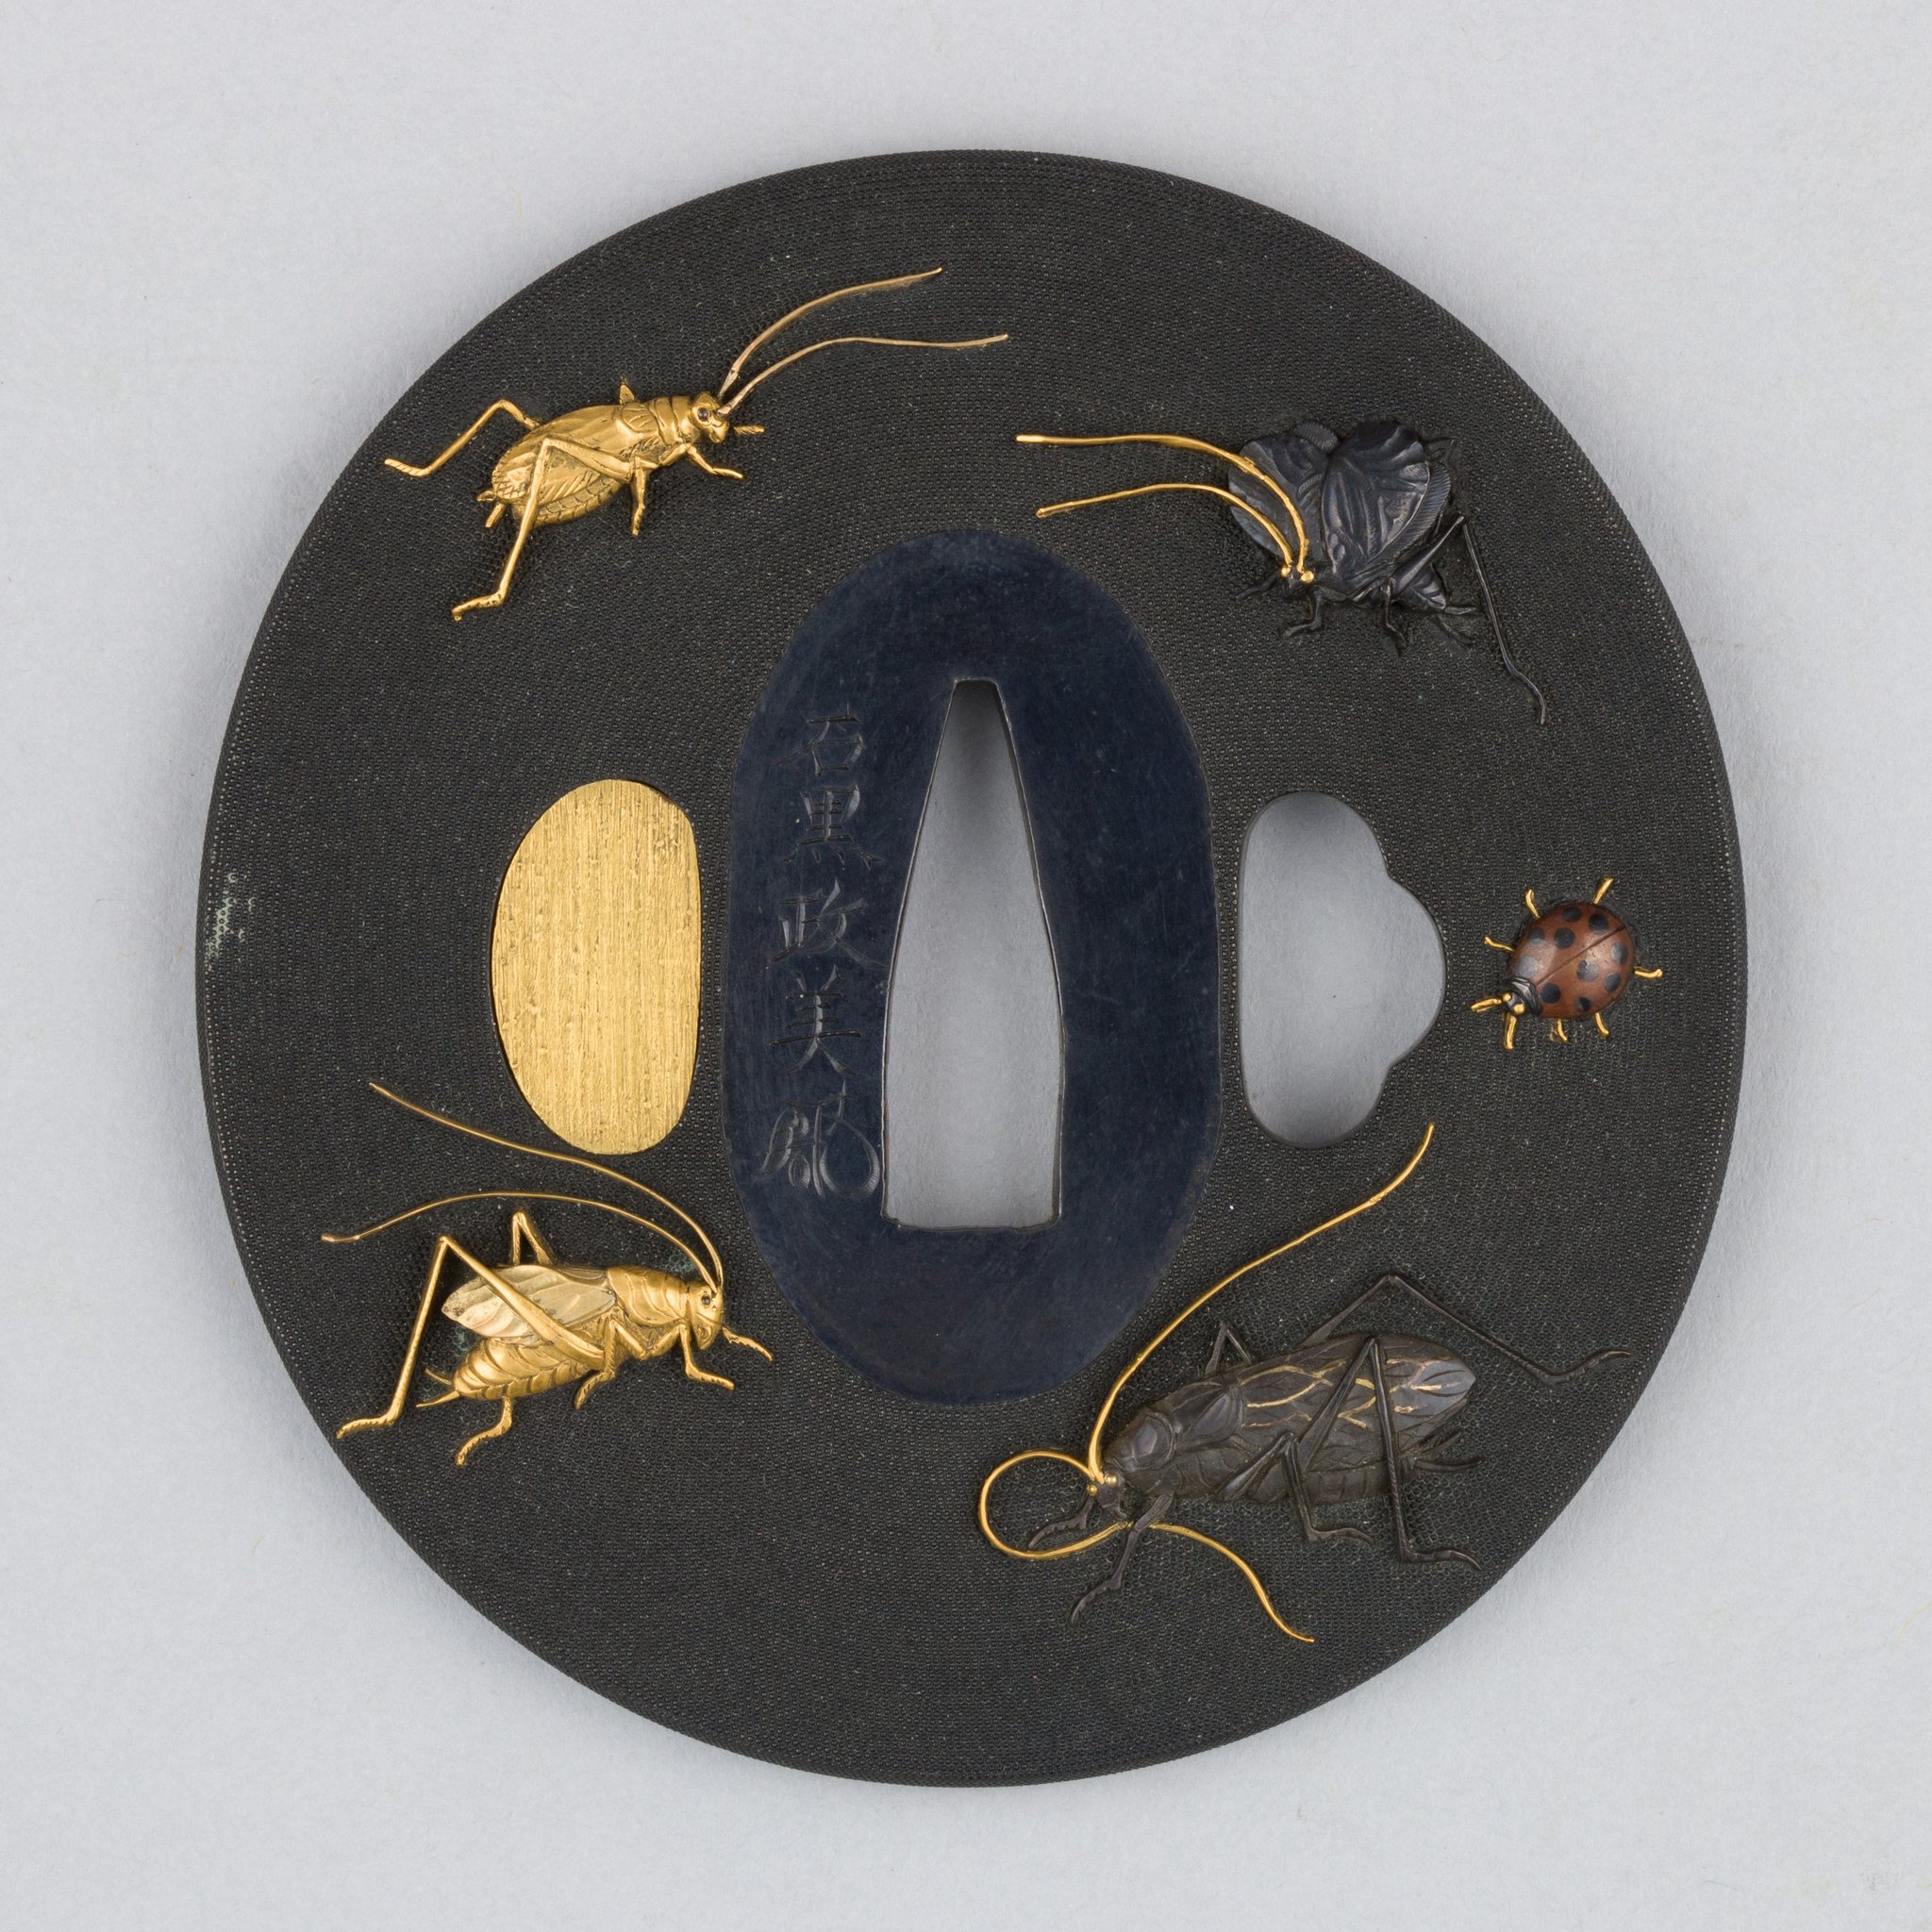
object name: sword guard tsuba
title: Sword Guard (Tsuba)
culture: japanese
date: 1701-1750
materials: copper, gold alloy, silver alloy, gold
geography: japan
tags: insects